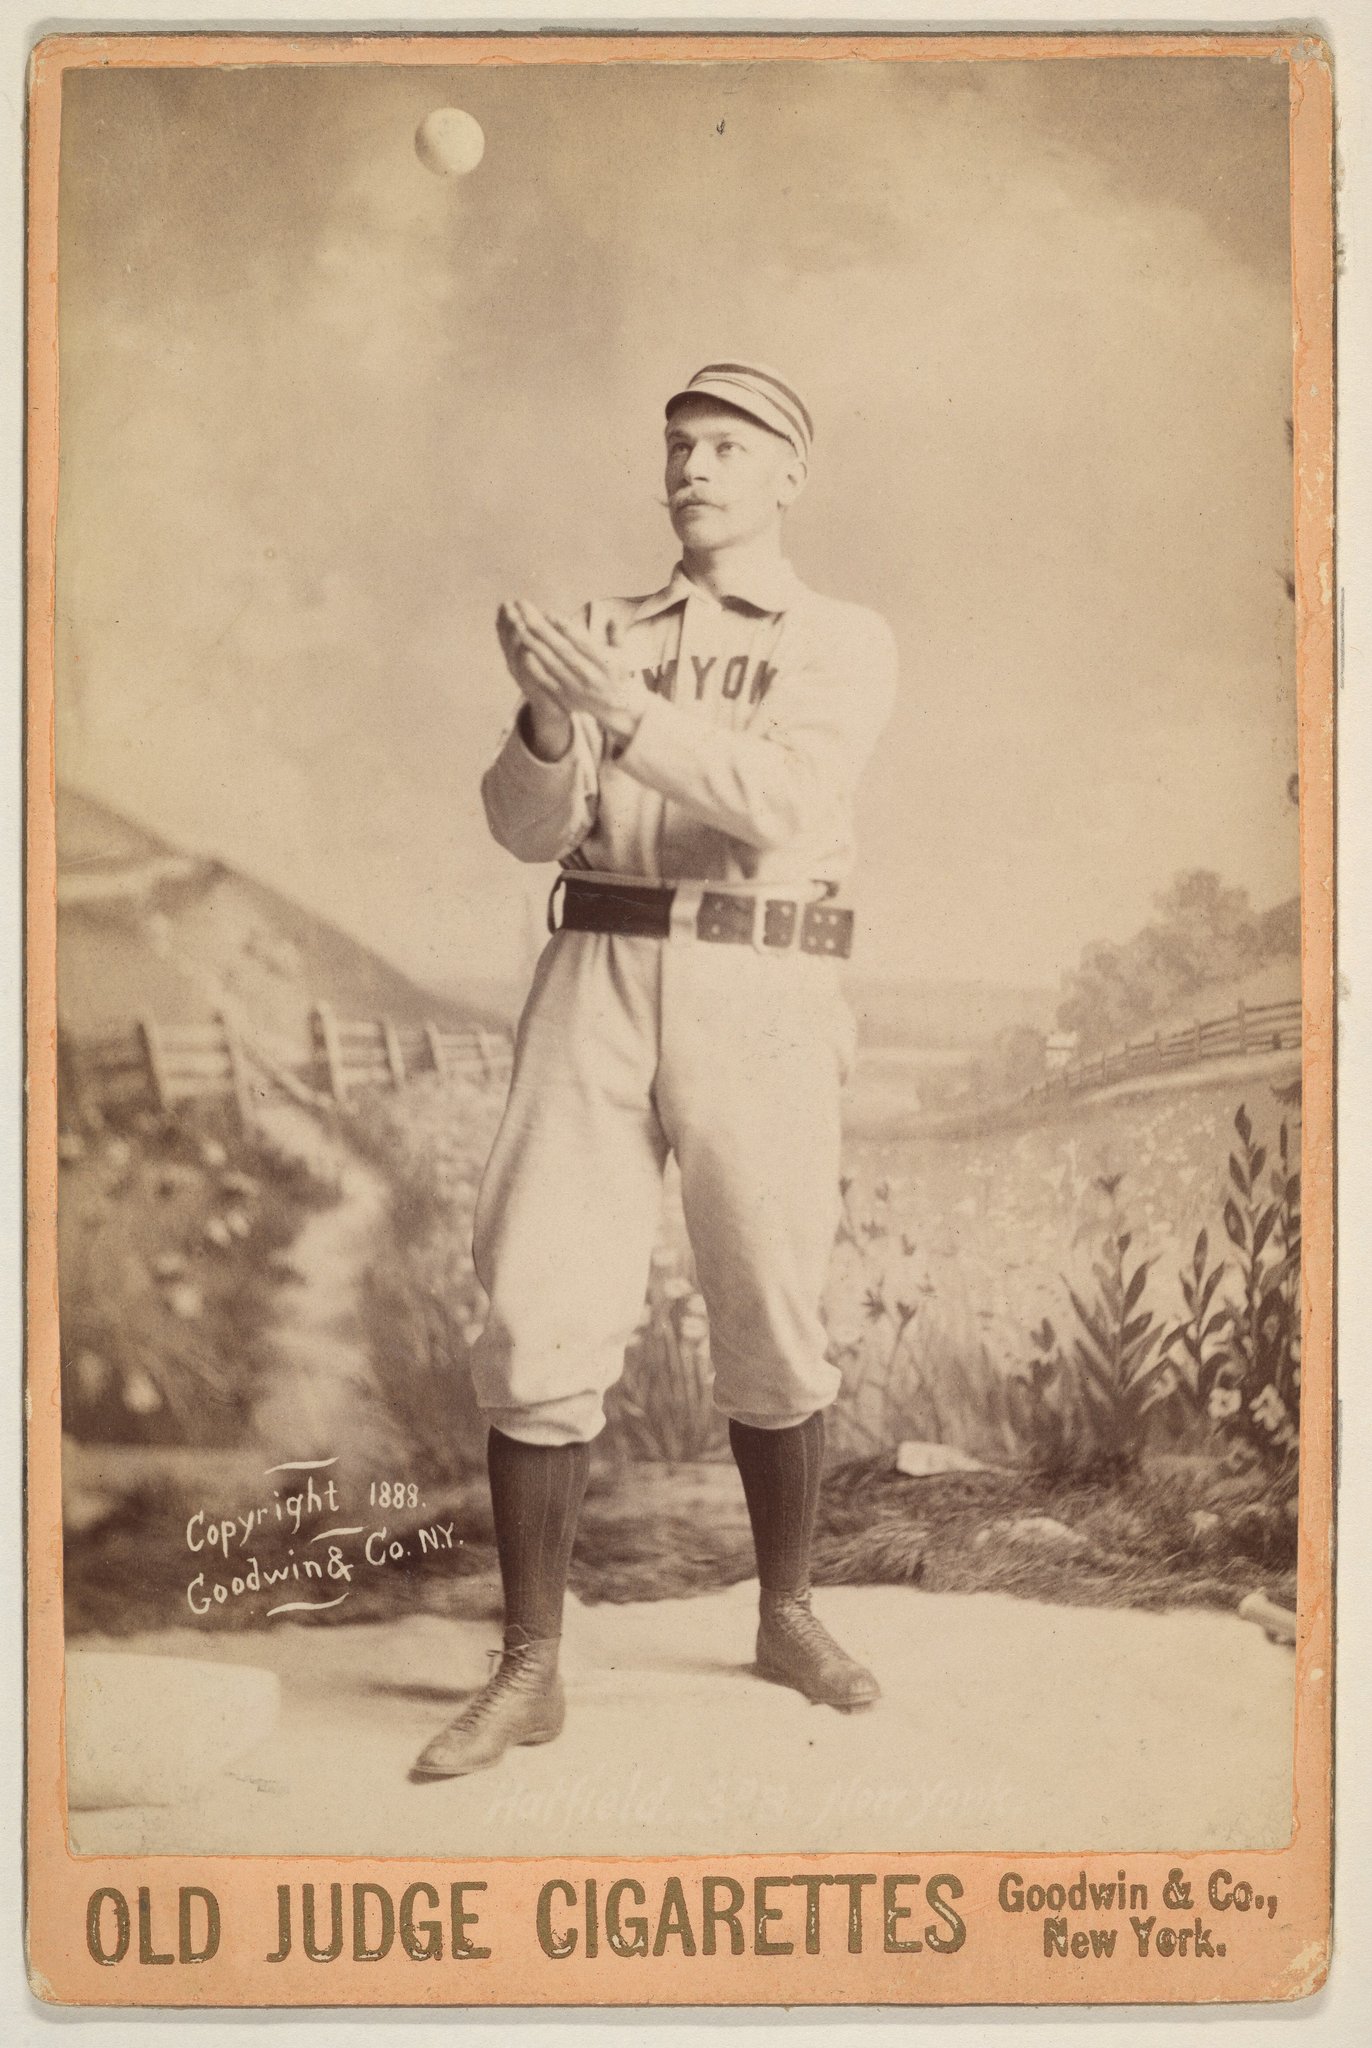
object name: baseball card, photograph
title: Hatfield, 3rd Base, New York, from the series Old Judge Cigarettes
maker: goodwin & company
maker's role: publisher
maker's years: 1850-1950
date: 1888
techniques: albumen silver print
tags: men,portraits,baseball,athletes